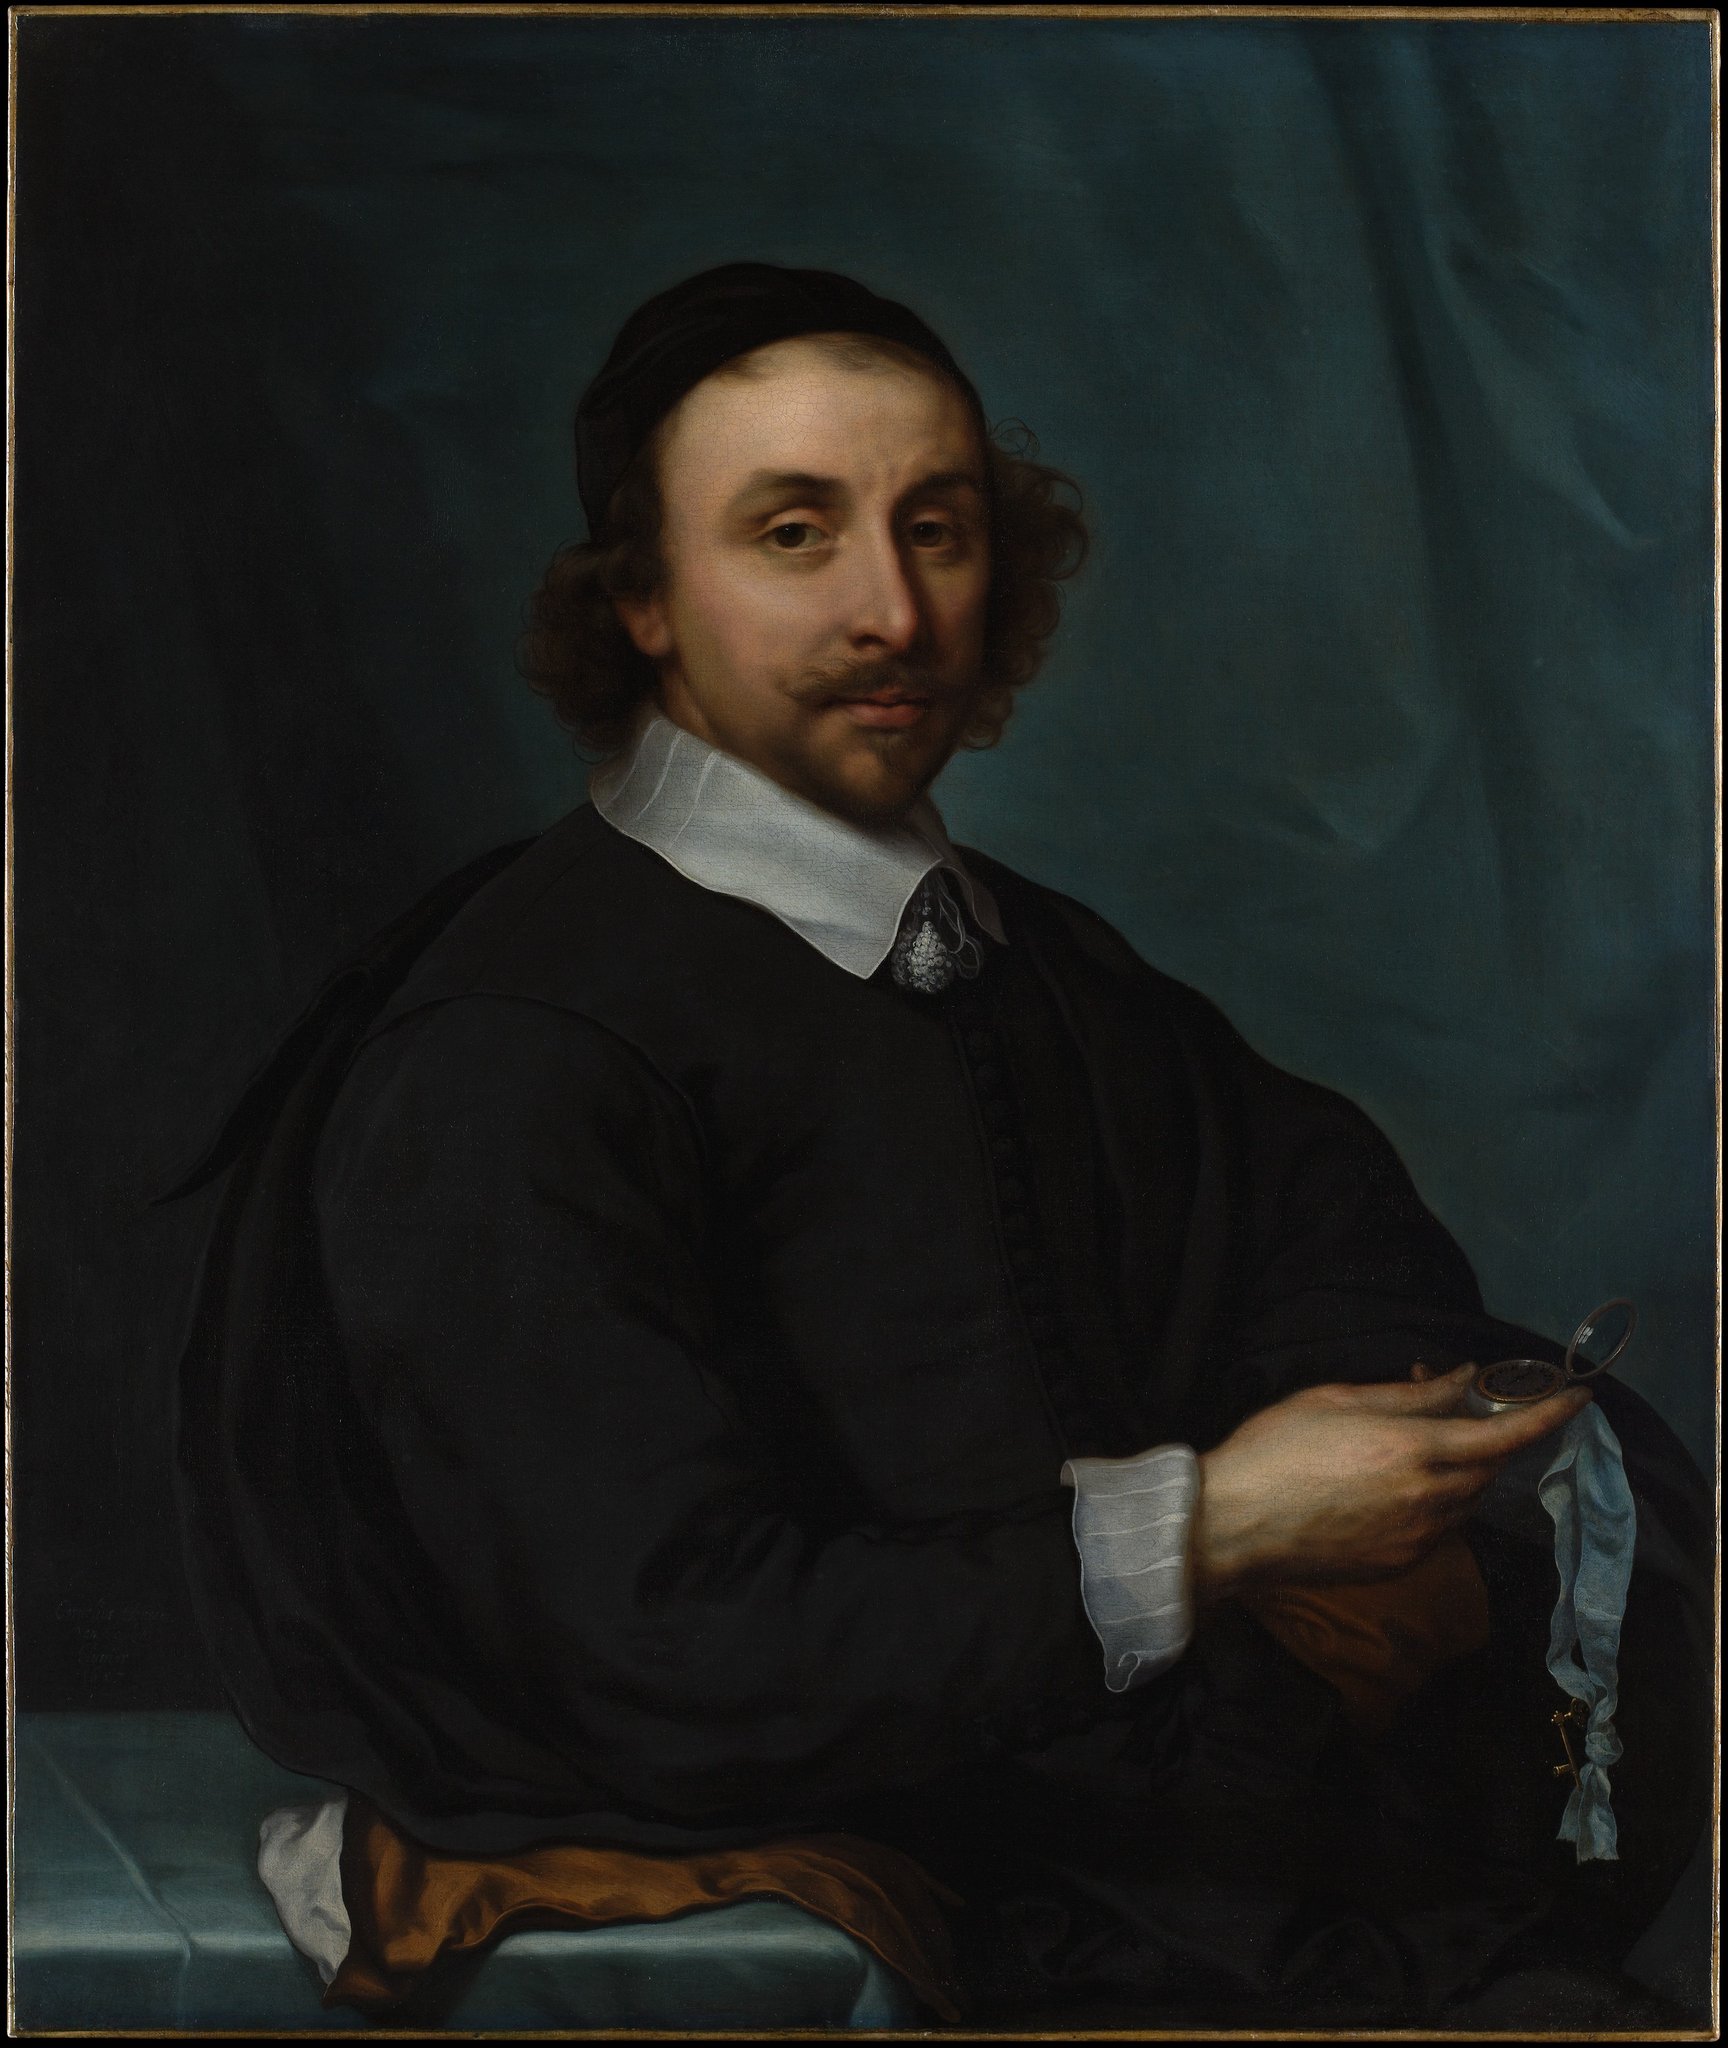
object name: painting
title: Portrait of a Man with a Watch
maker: cornelis jonson van ceulen the younger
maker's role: artist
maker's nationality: dutch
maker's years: 1634-1715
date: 1657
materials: canvas, oil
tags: watches,men,portraits